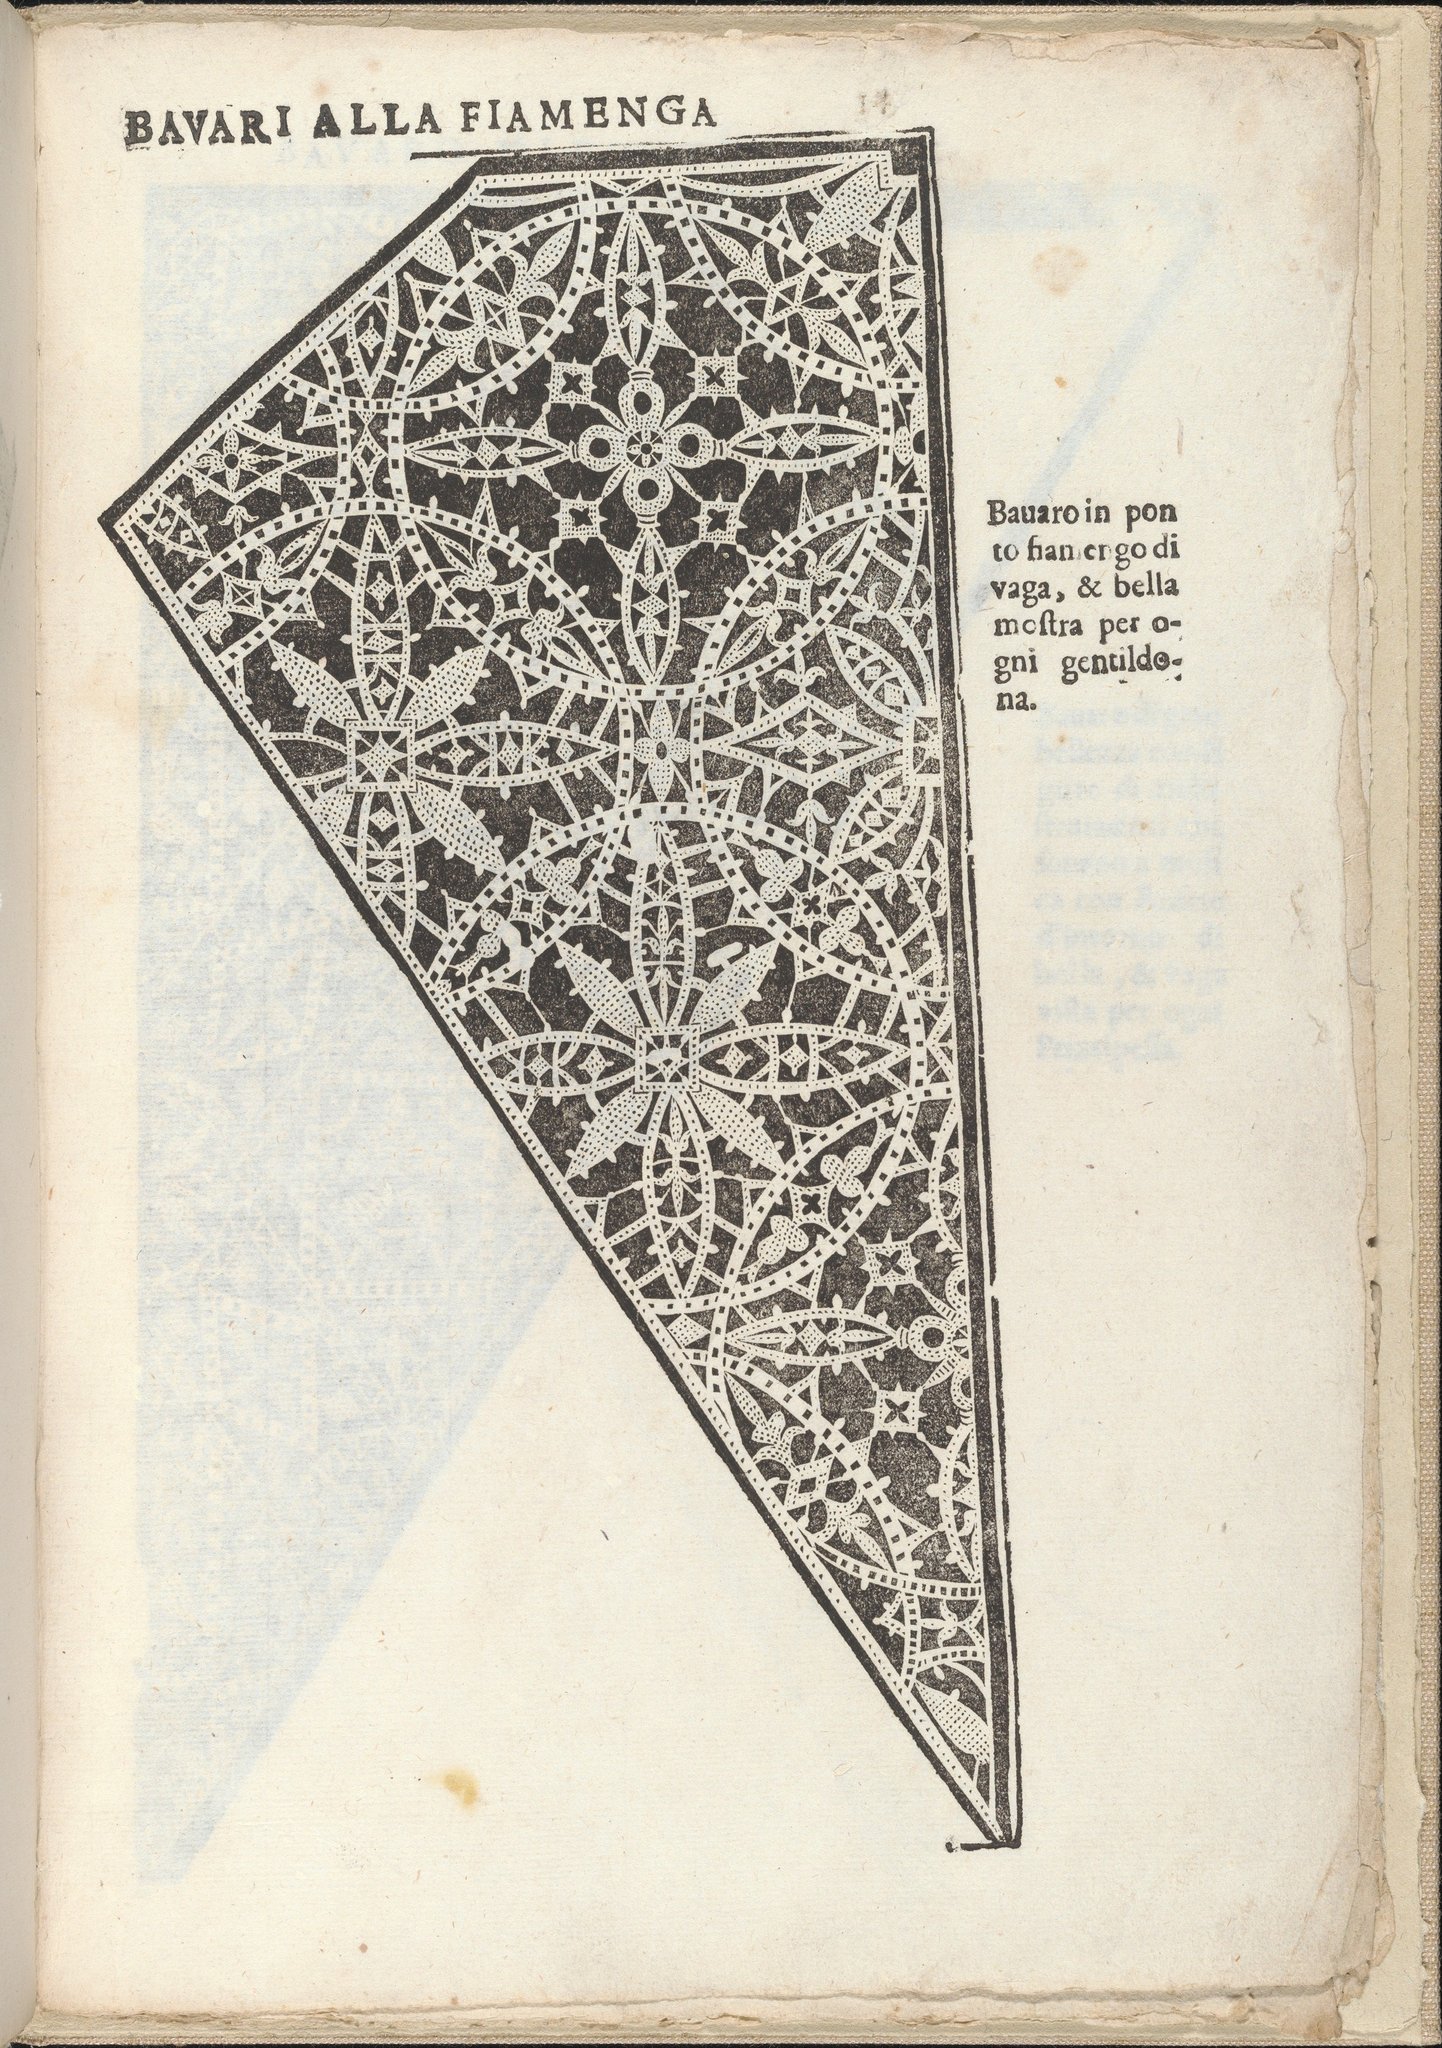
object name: book print ornament architecture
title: Ornamento nobile...Fatta da Lucretia Romana (Libro V of the Corona), page 10 (recto)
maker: cesare vecellio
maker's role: author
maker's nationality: italian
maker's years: 1521-1601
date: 1620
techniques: woodcut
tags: ornament